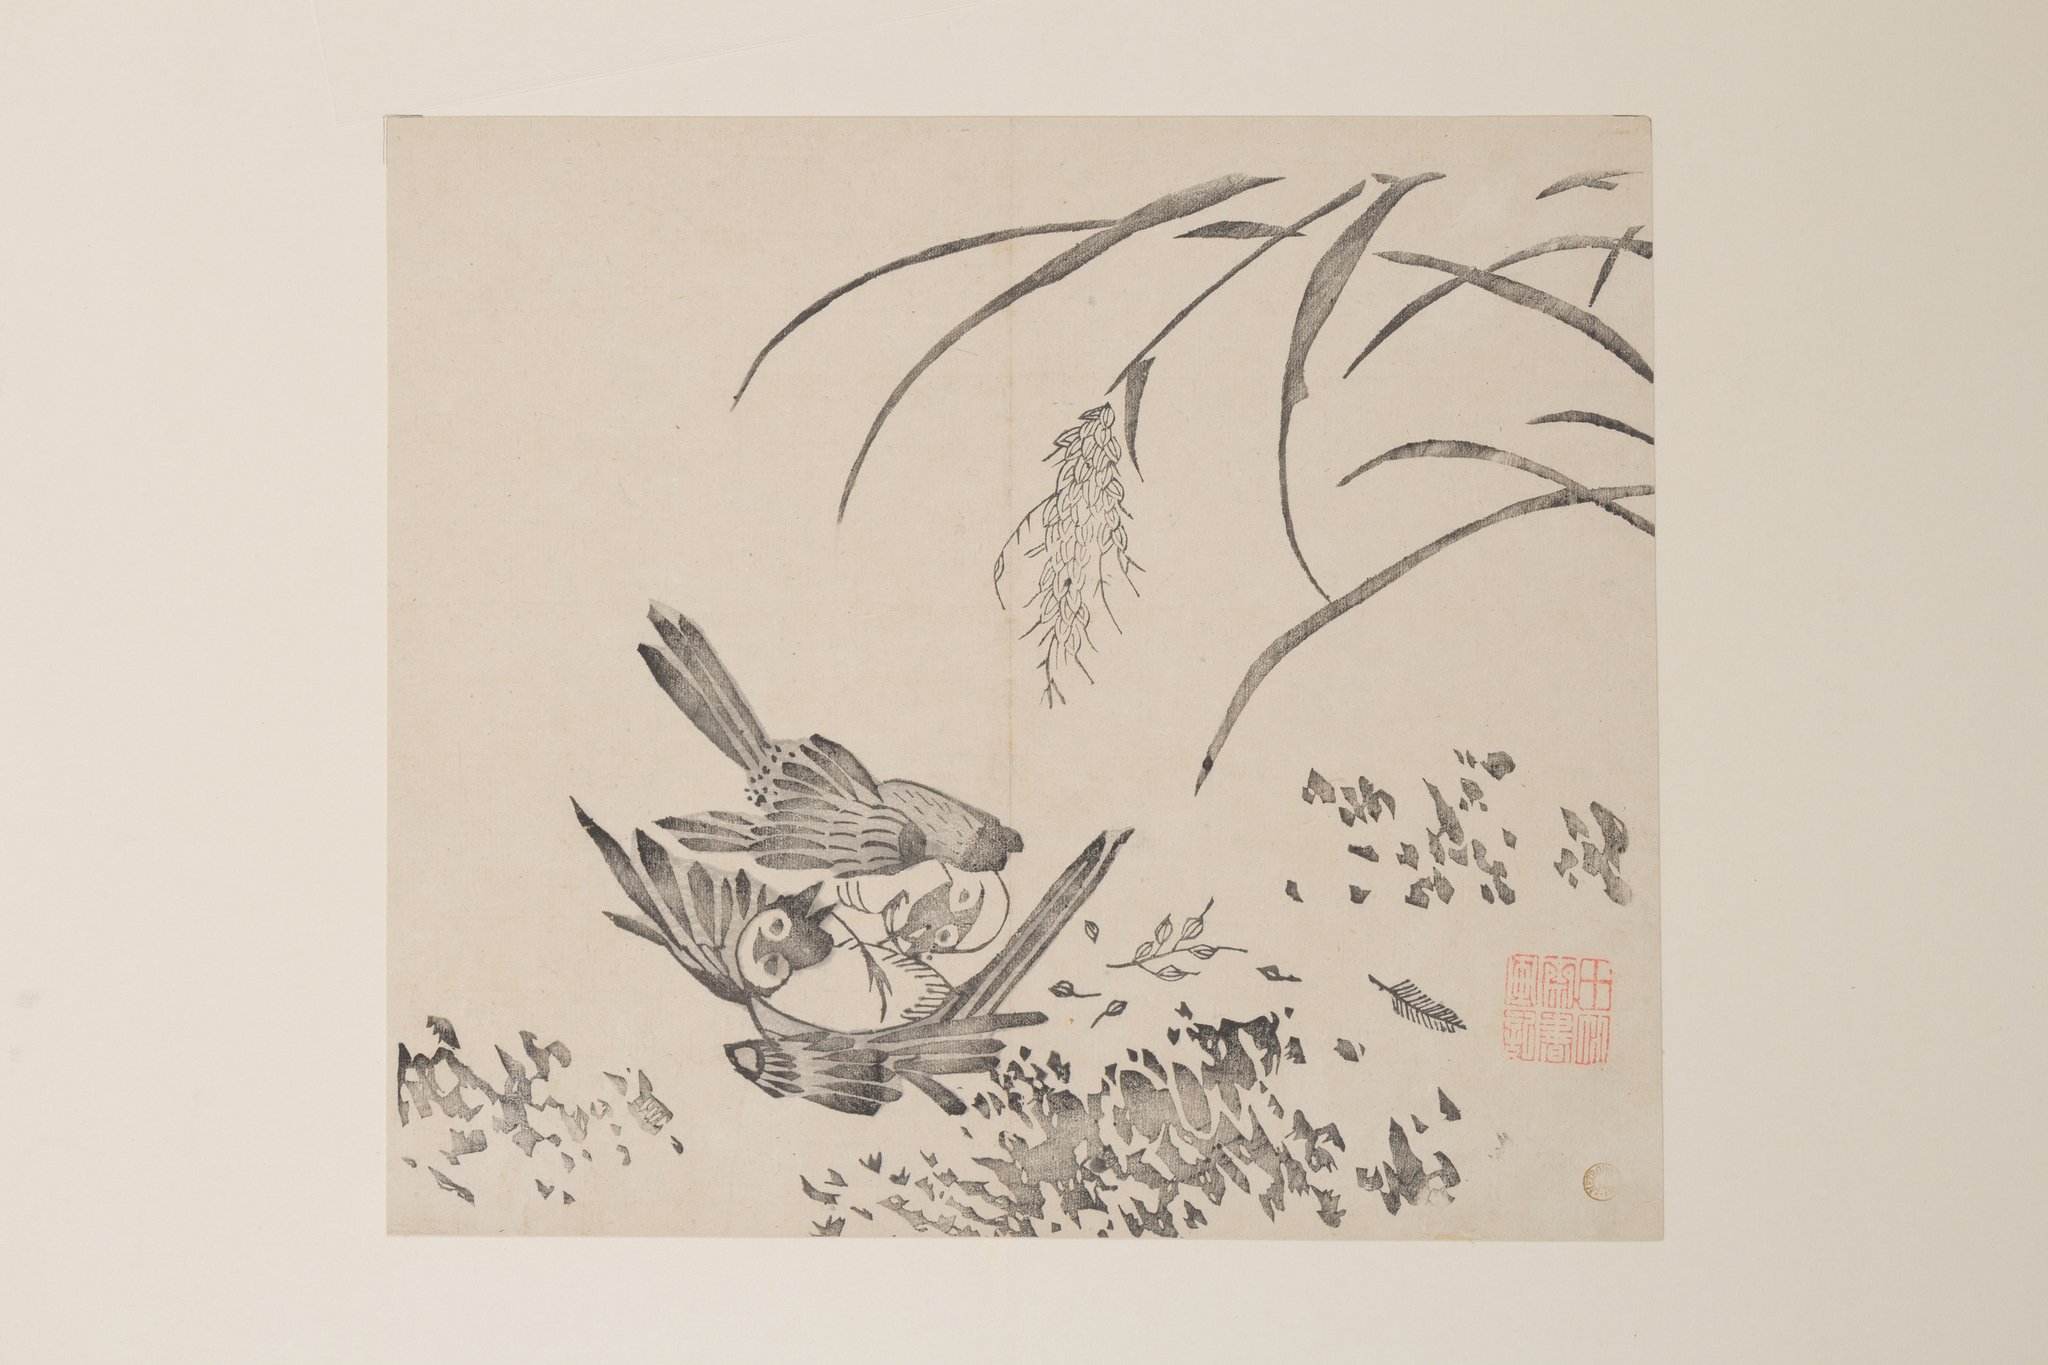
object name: print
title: Leaf from the Ten Bamboo Studio Manual of Painting and Calligraphy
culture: chinese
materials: ink, paper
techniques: printing